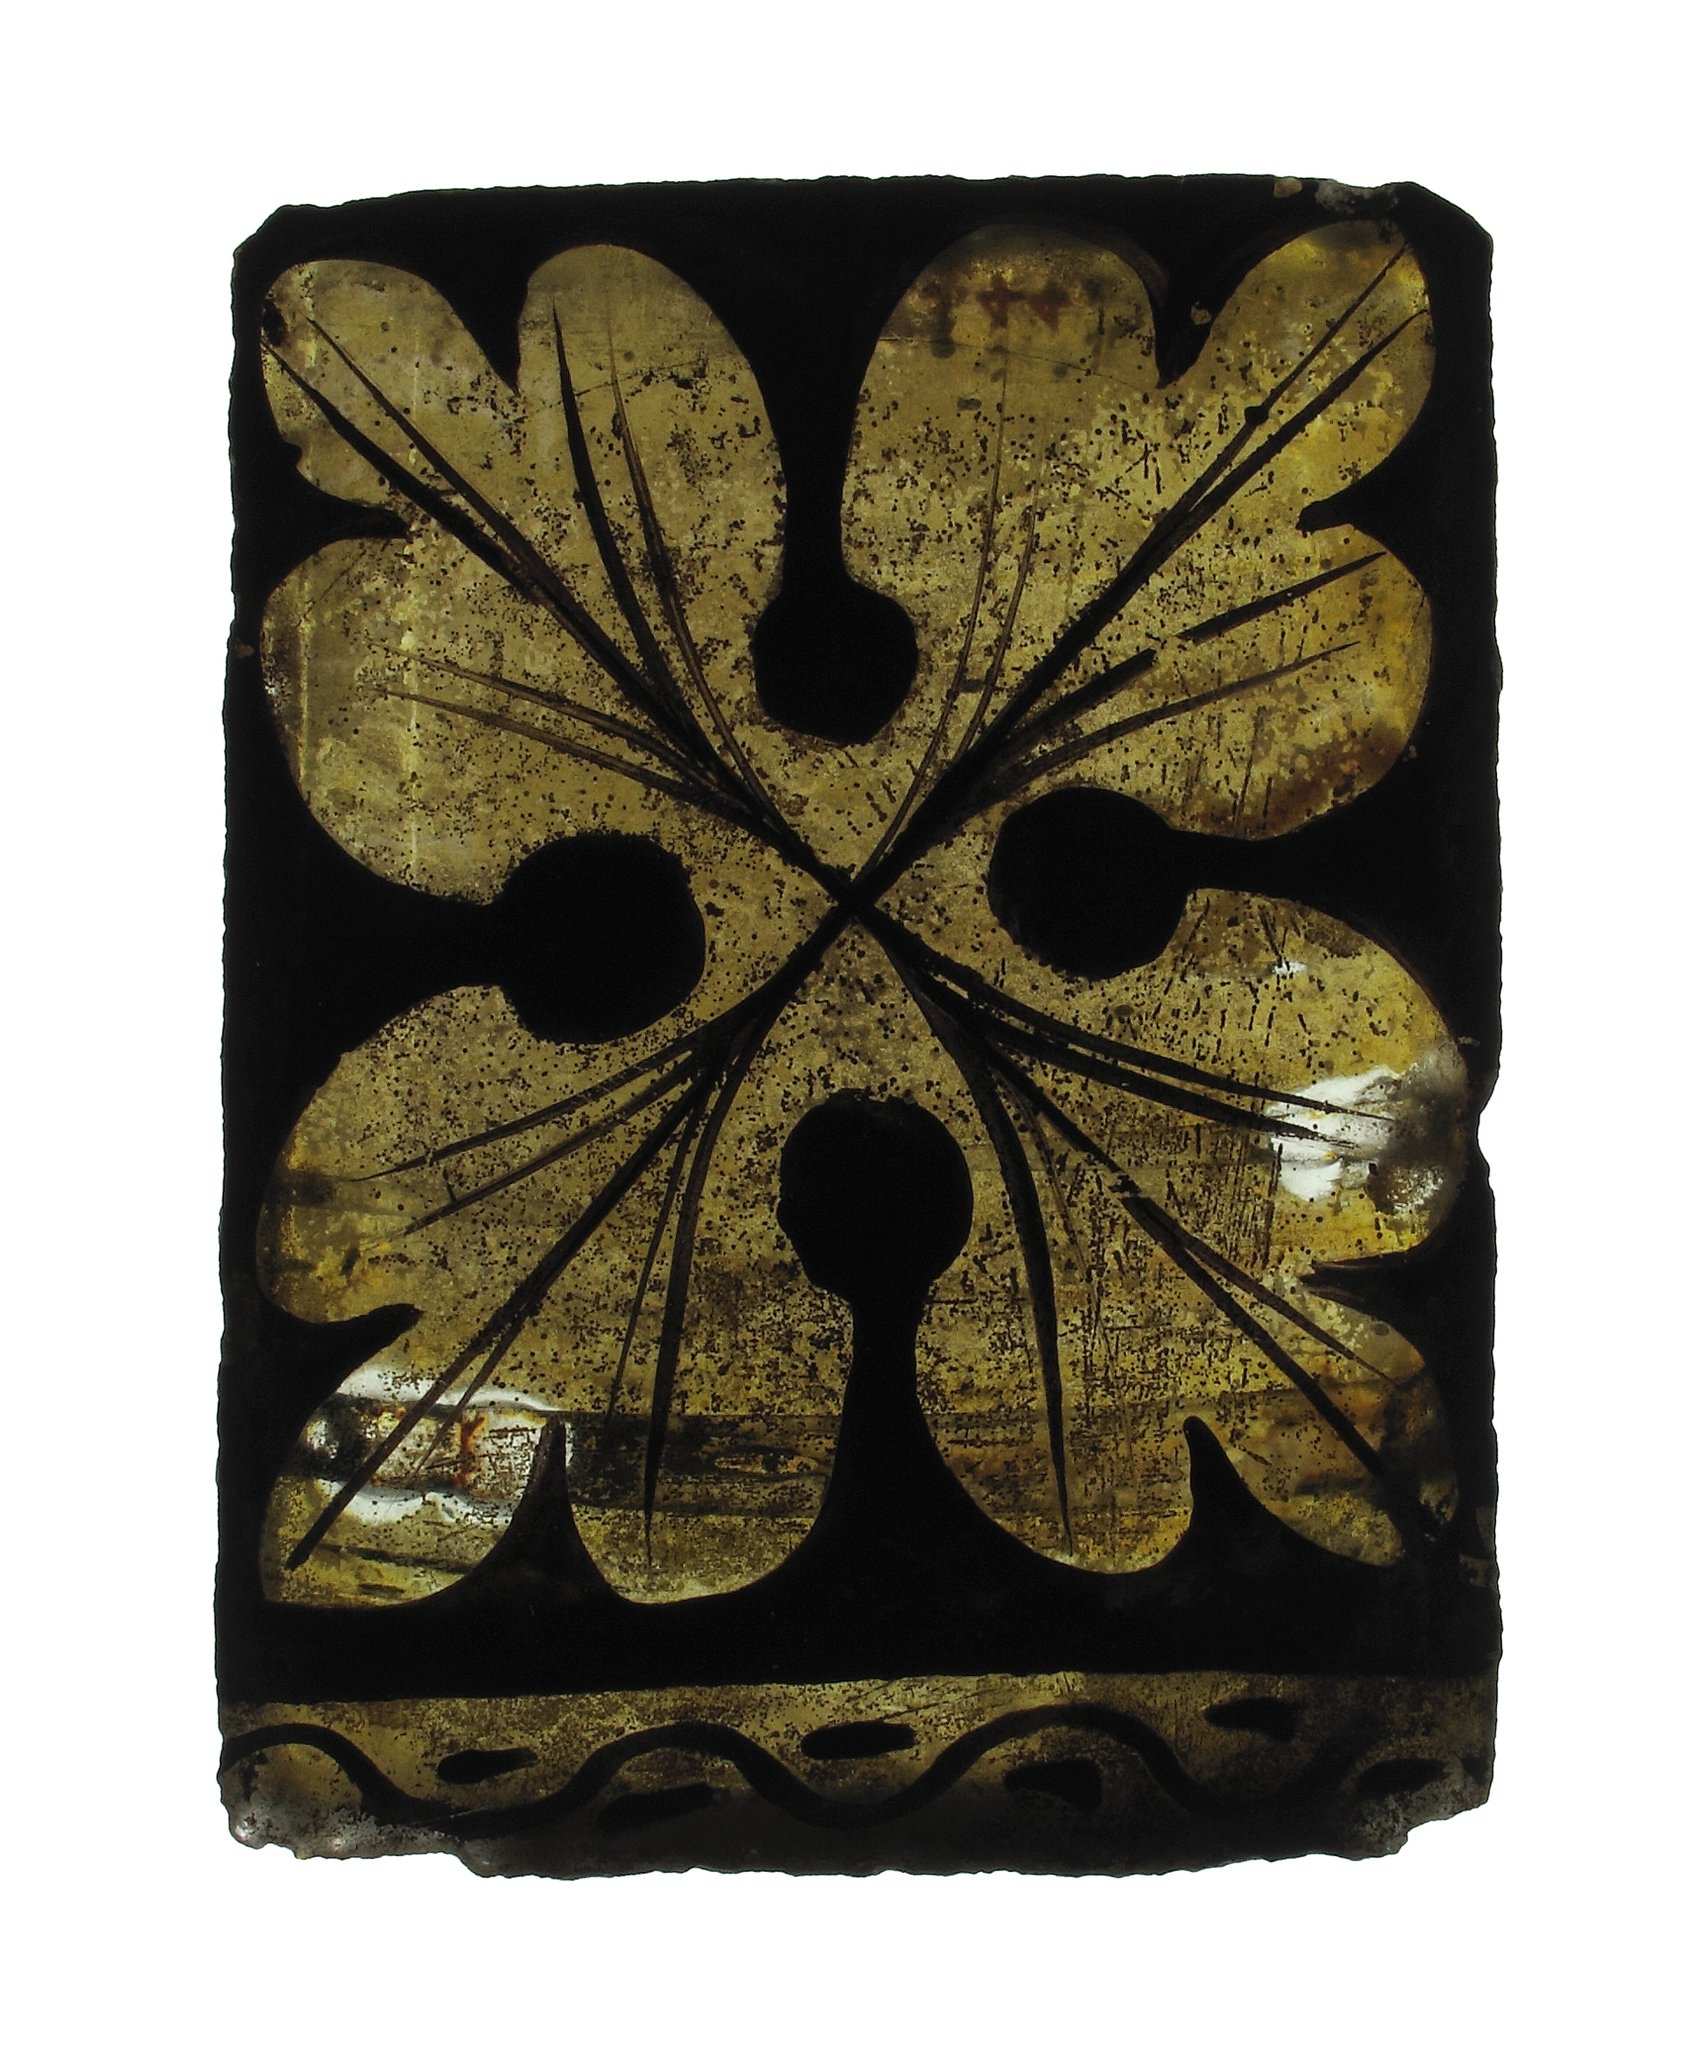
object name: fragment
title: Glass Fragment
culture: european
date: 1301-1400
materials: glass